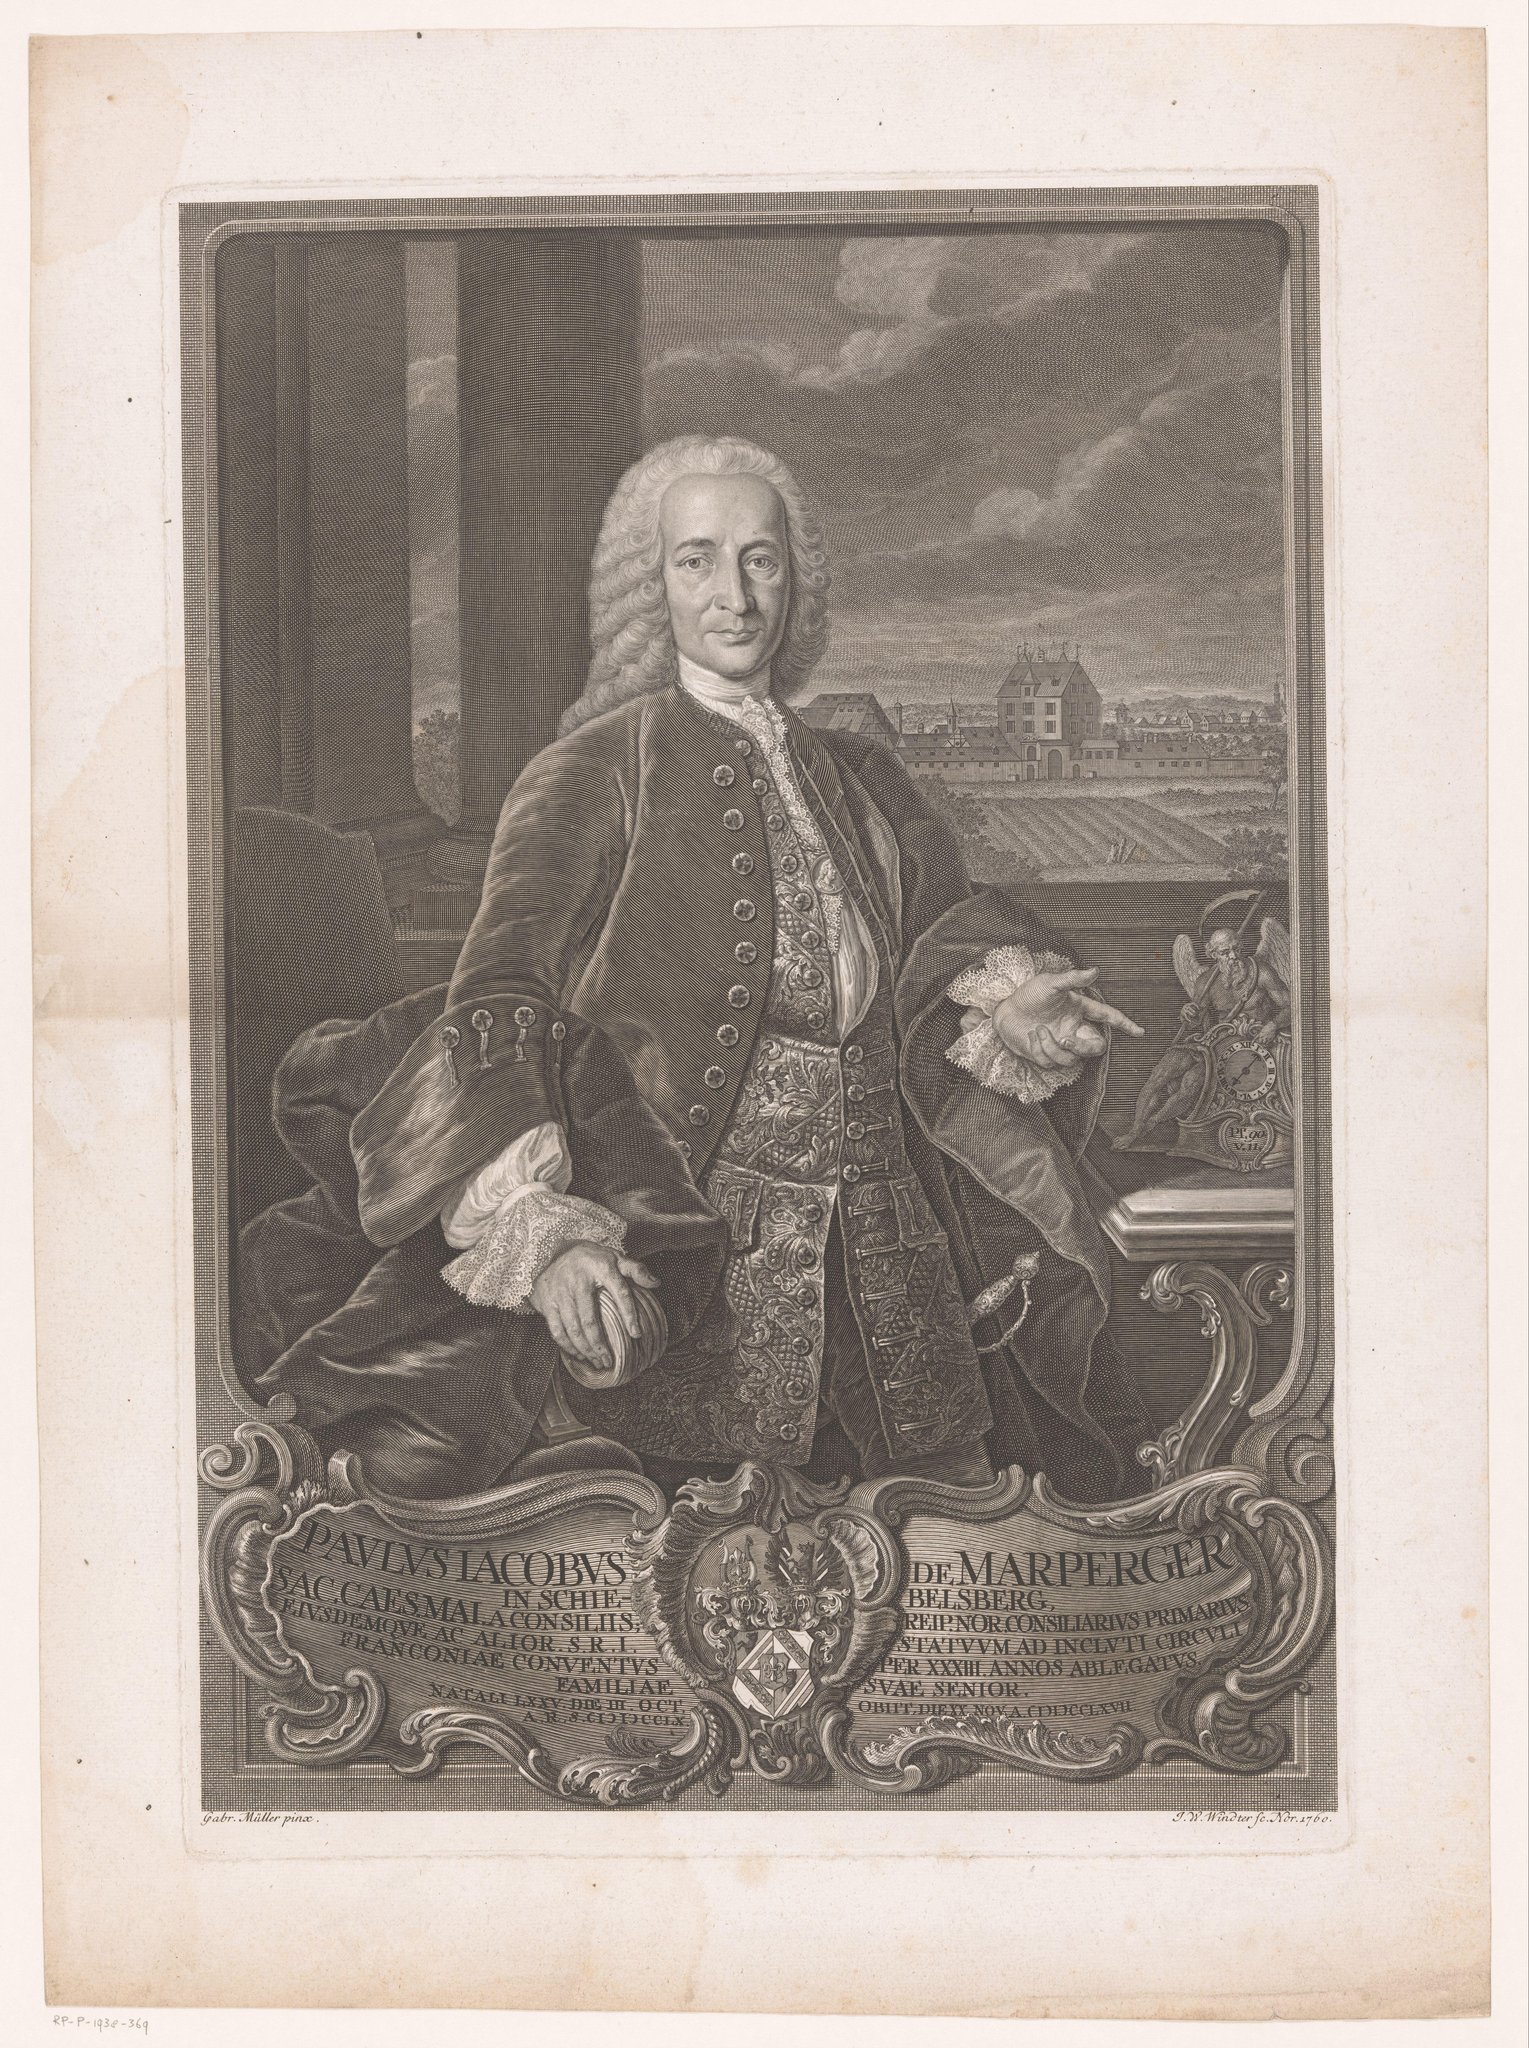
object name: print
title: Portret van Paul Jacob von Marperger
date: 1760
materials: paper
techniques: engraving, etching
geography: nuremberg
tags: historical persons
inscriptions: collector's mark: Lugt 2228